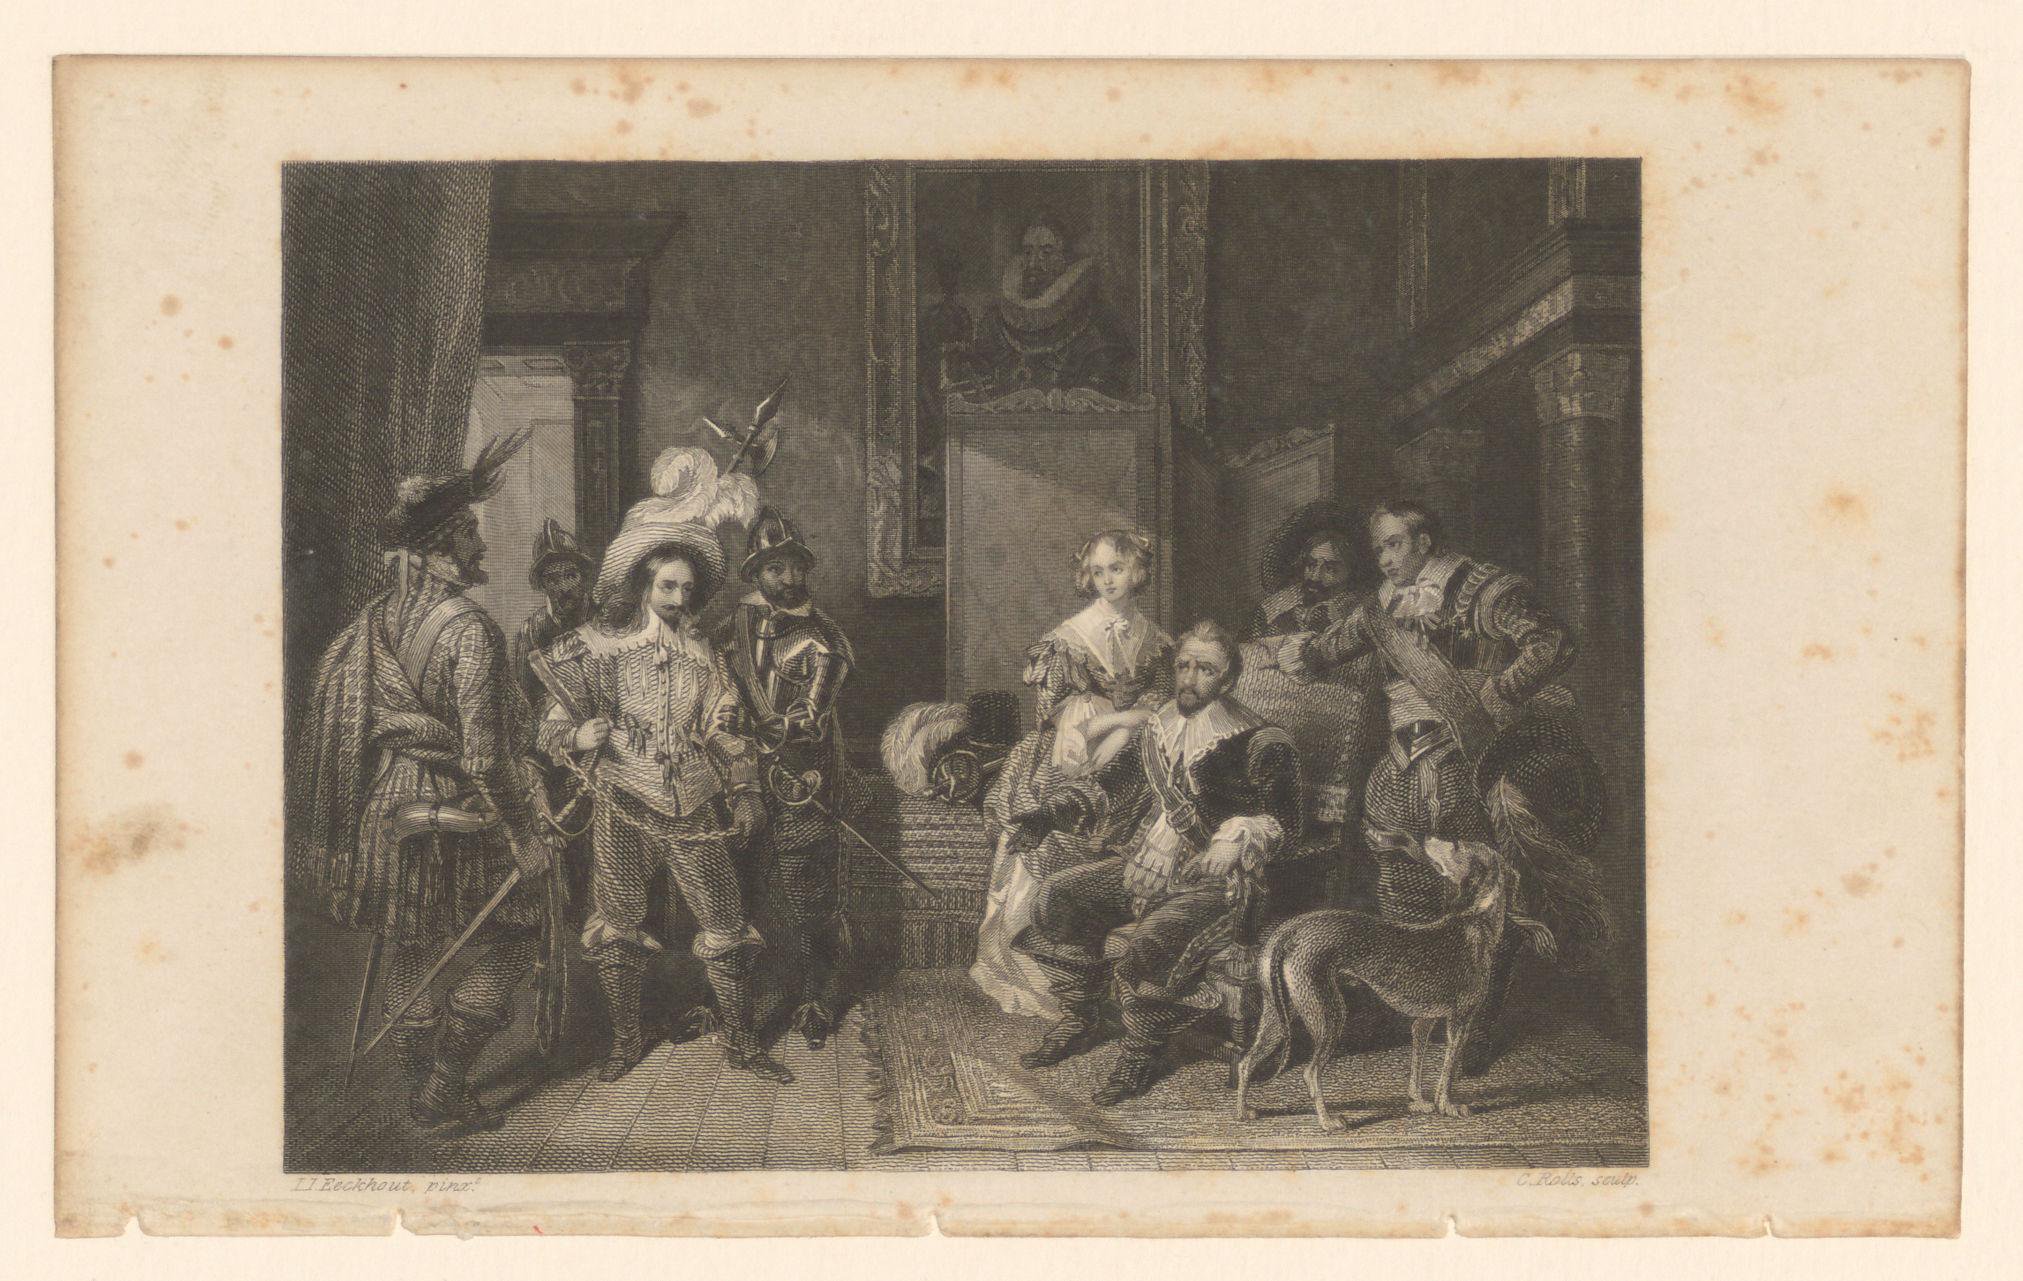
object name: print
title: Gevangene wordt voor een hooggeplaatste man gebracht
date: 1810-1842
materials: paper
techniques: engraving, etching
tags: prisoner with hands bound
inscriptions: annotation: ‘[...] Dilthey voor Cromwell uit Aurora 1842’, collector's mark: Lugt 2228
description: Prent is gebruikt in: Aurora. Jaarboekje voor 1842. Den Haag: J.I.D. Nepveu, 1842.